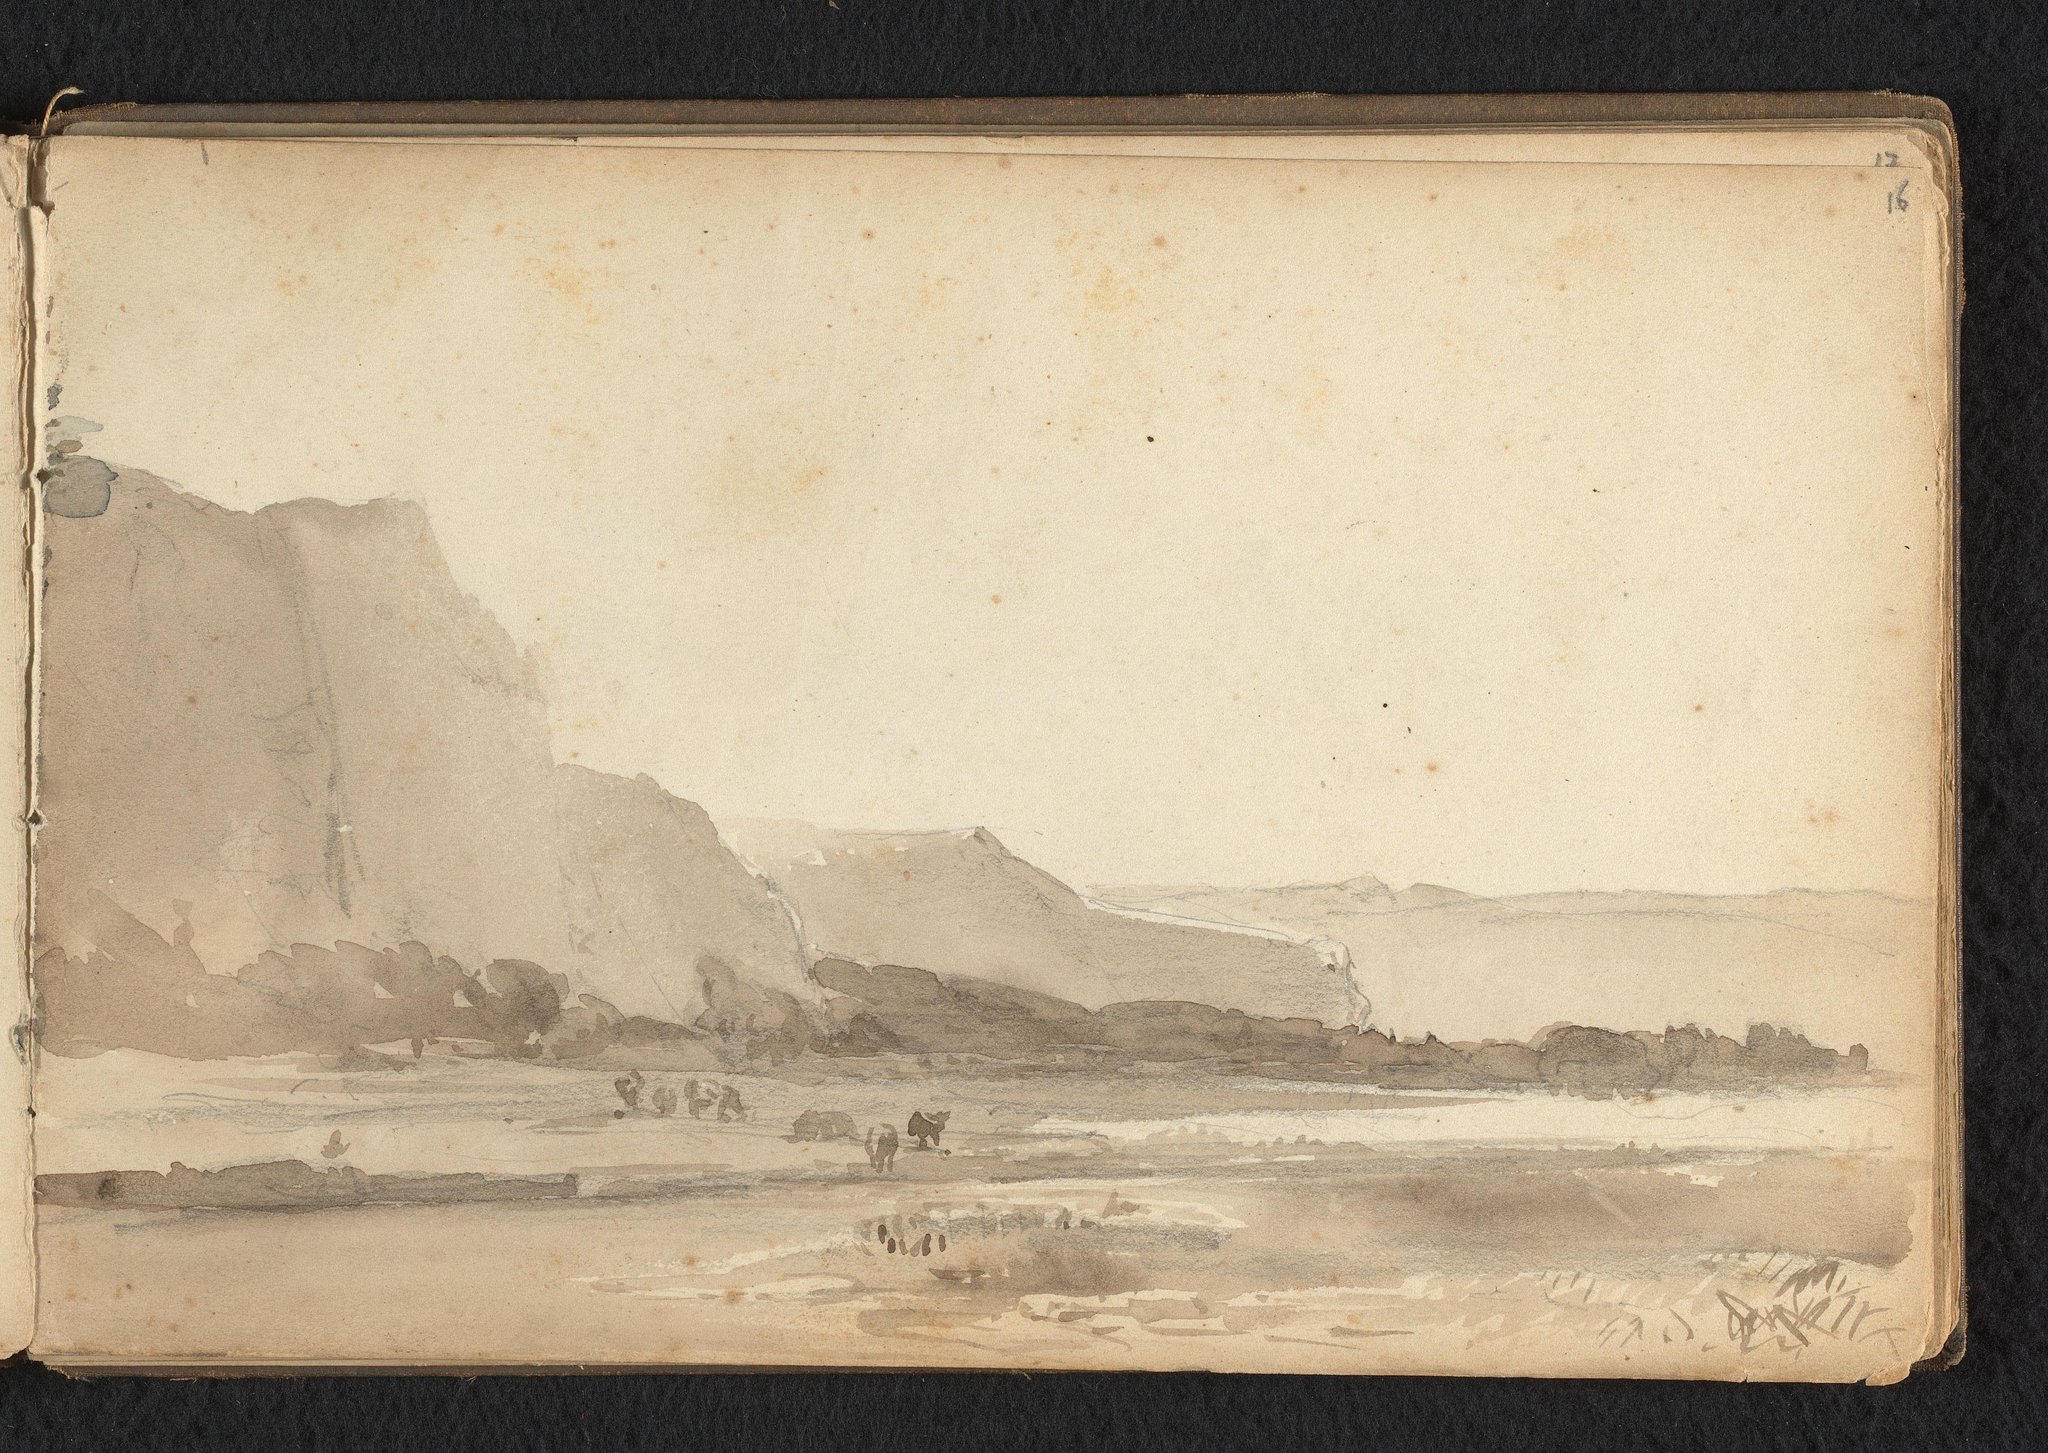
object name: sketchbook leaf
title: Heuvelig landschap met vee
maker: jan bedijs tom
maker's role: draughtsman, painter, print maker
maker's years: 1813-1894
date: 1823-1894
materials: paper, pencil, watercolor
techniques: brush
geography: the hague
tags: low hill country, bovine cattle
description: Pagina 16 recto uit een schetsboek met 37 bladen.